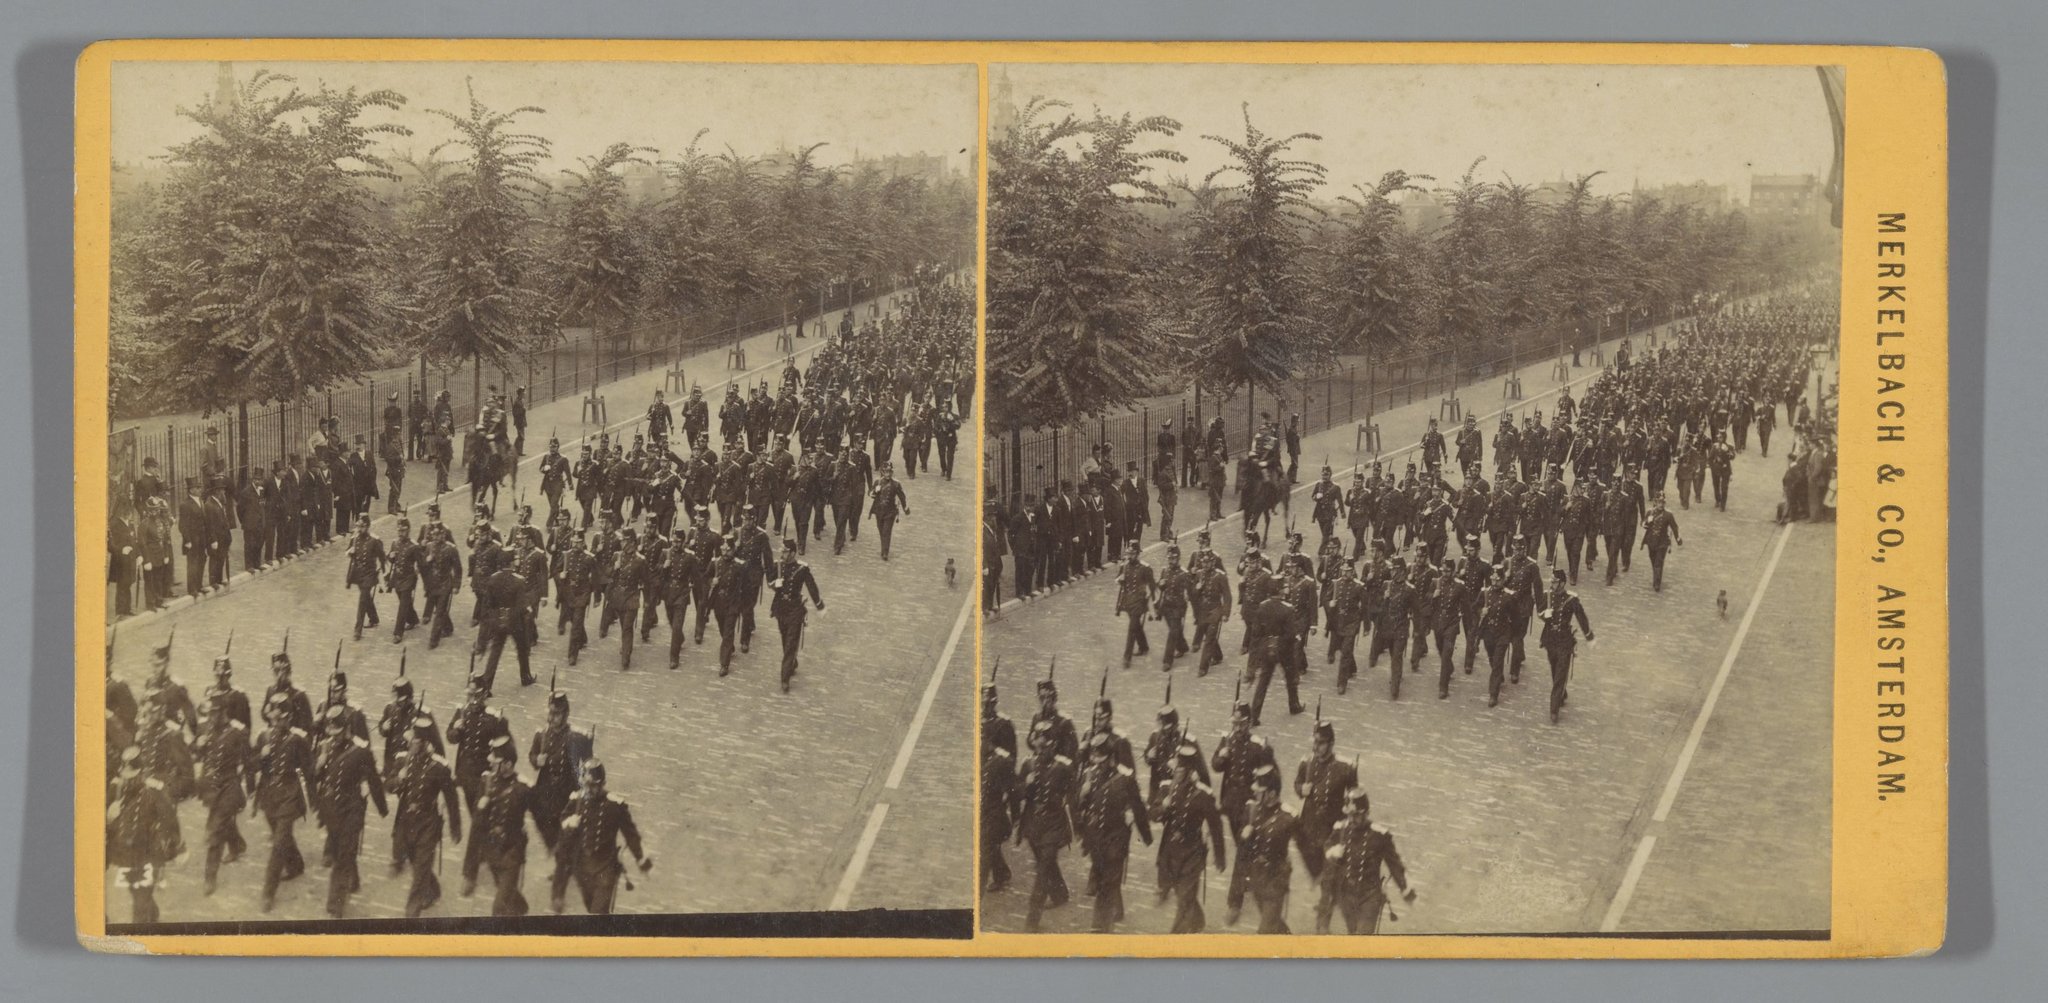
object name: stereograph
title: Aardrijkskundige beeldengalerij, verzameld door M.J. Broekhuijsen, hoofd eener school te Amsterdam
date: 1900-1902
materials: cardboard, paper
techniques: albumen print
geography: amsterdam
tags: military parade, pageant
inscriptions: inscription: ‘E.3.’, inscription: ‘van de Amsterdamsche schutterij achter het Oosterpark.’, number: ‘3.’